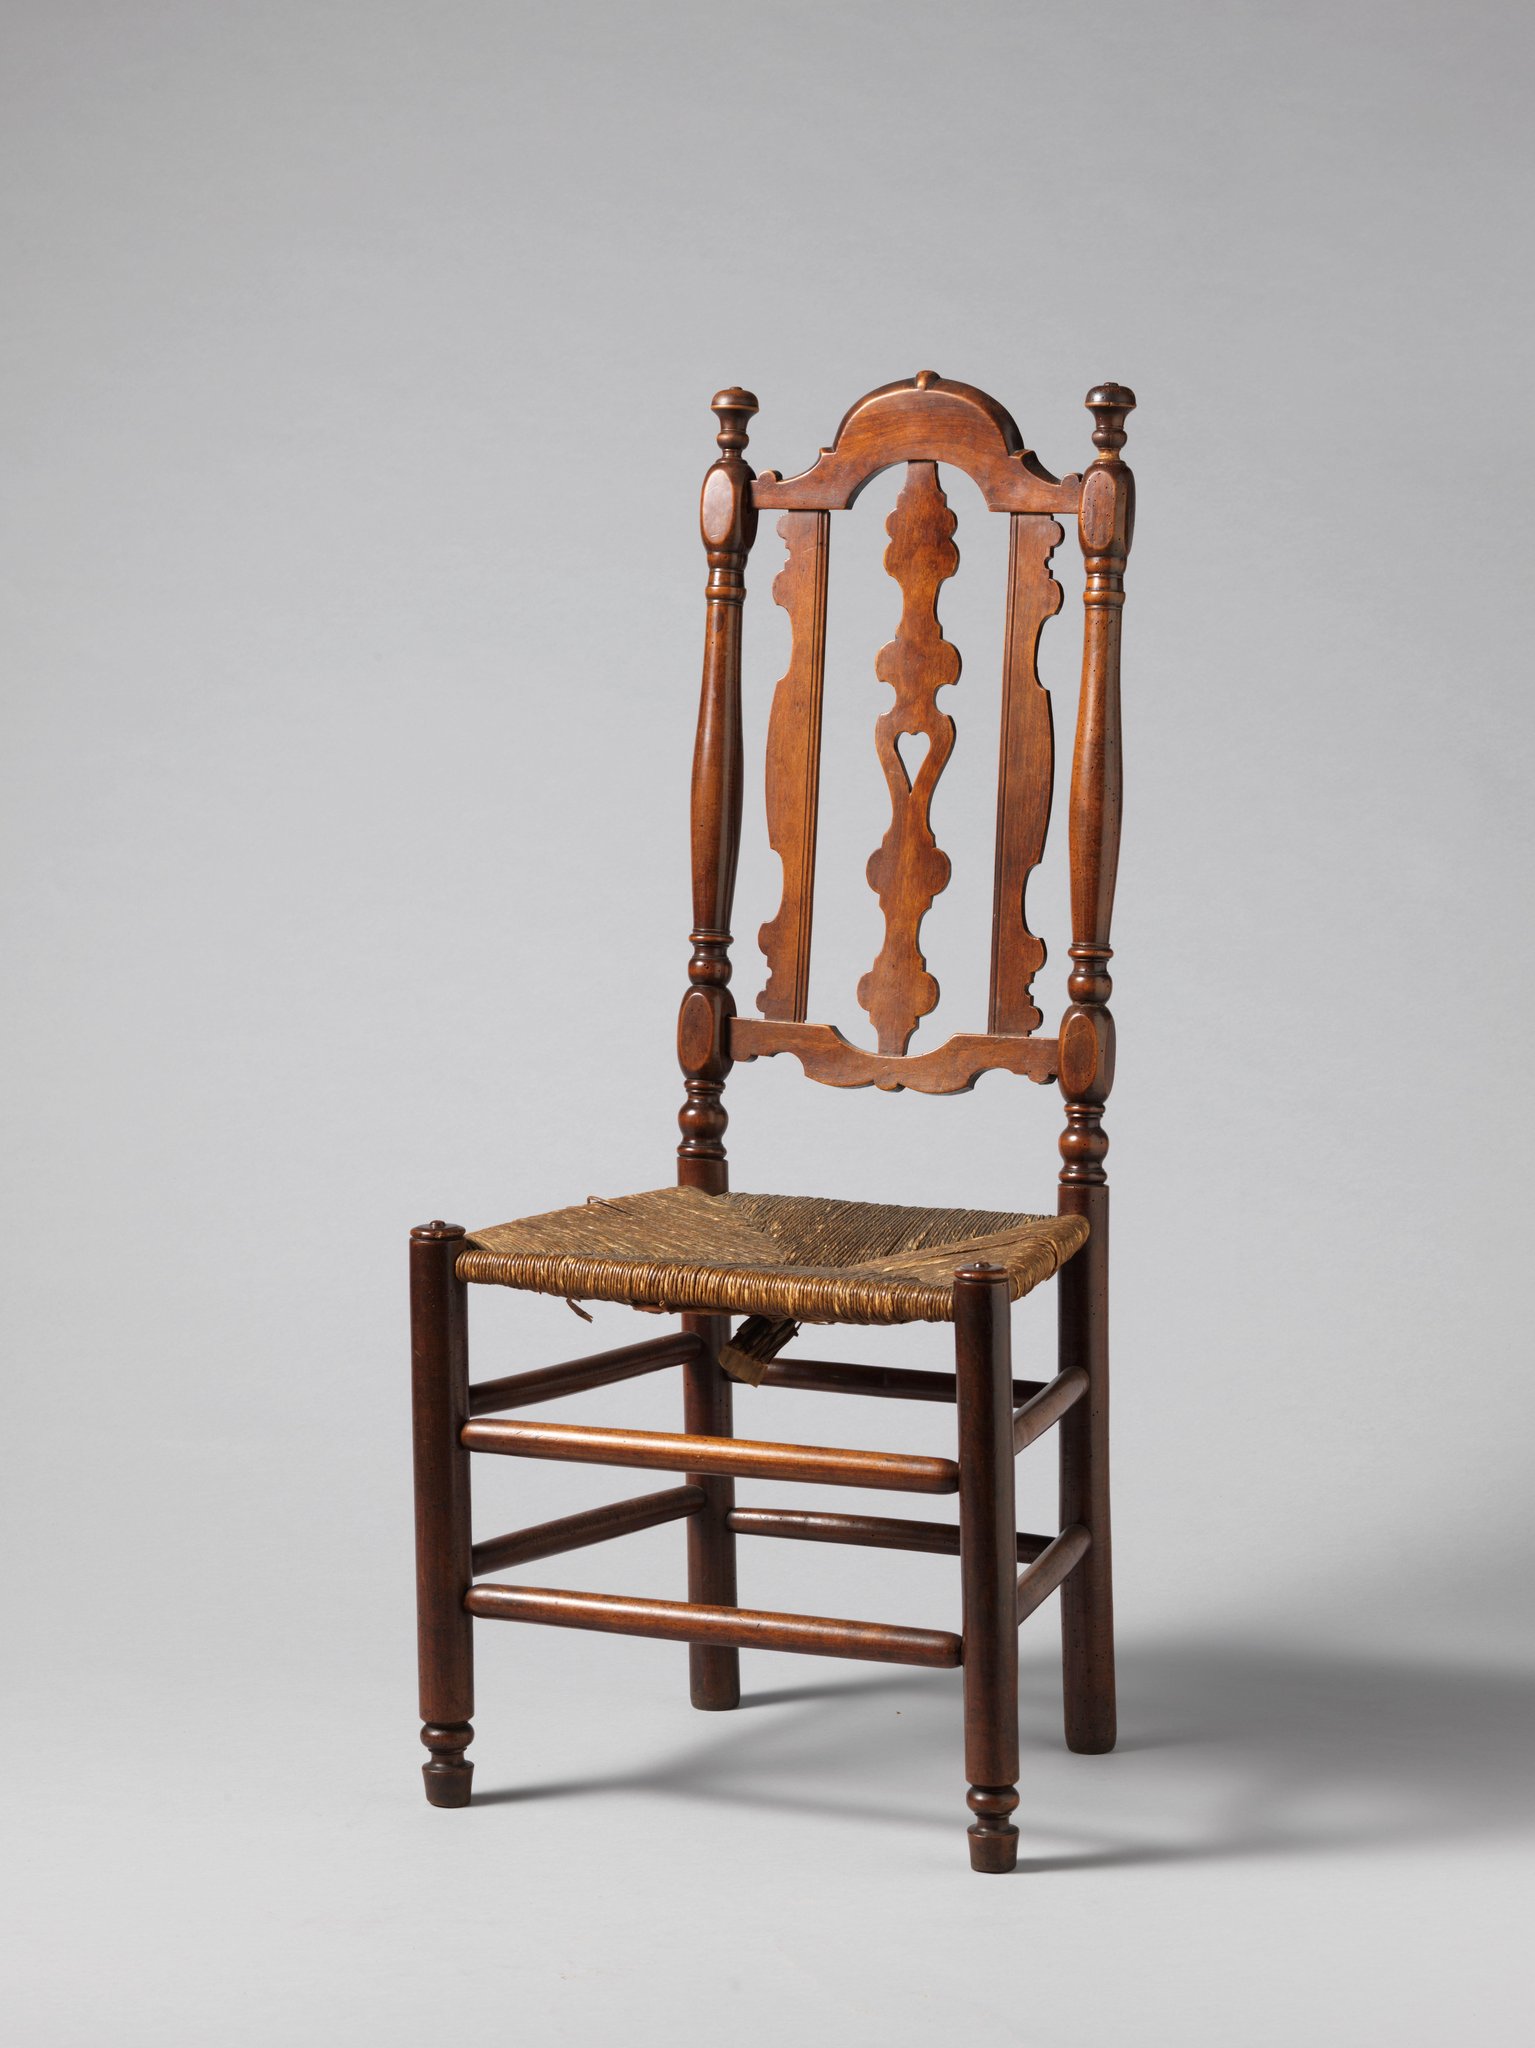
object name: chair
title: Stoel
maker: Anonymous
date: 1700-1750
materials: wood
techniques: caning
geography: northern netherlands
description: Stoel van kersenhout met matten zitting. De poten en de acht sporten zijn gedraaid. De hoekstijlen van de rug zijn kolomvormig geleed met verdikkingen in het midden. De onder- en bovendorpel zijn symmetrisch uitgezaagd, evenals de middenbaan die een opengewerkt hart als middenstuk vertoont en beide stijlen ter weerszijden. Als bekroning van de hoekstijlen zijn vaasjes aangebracht.